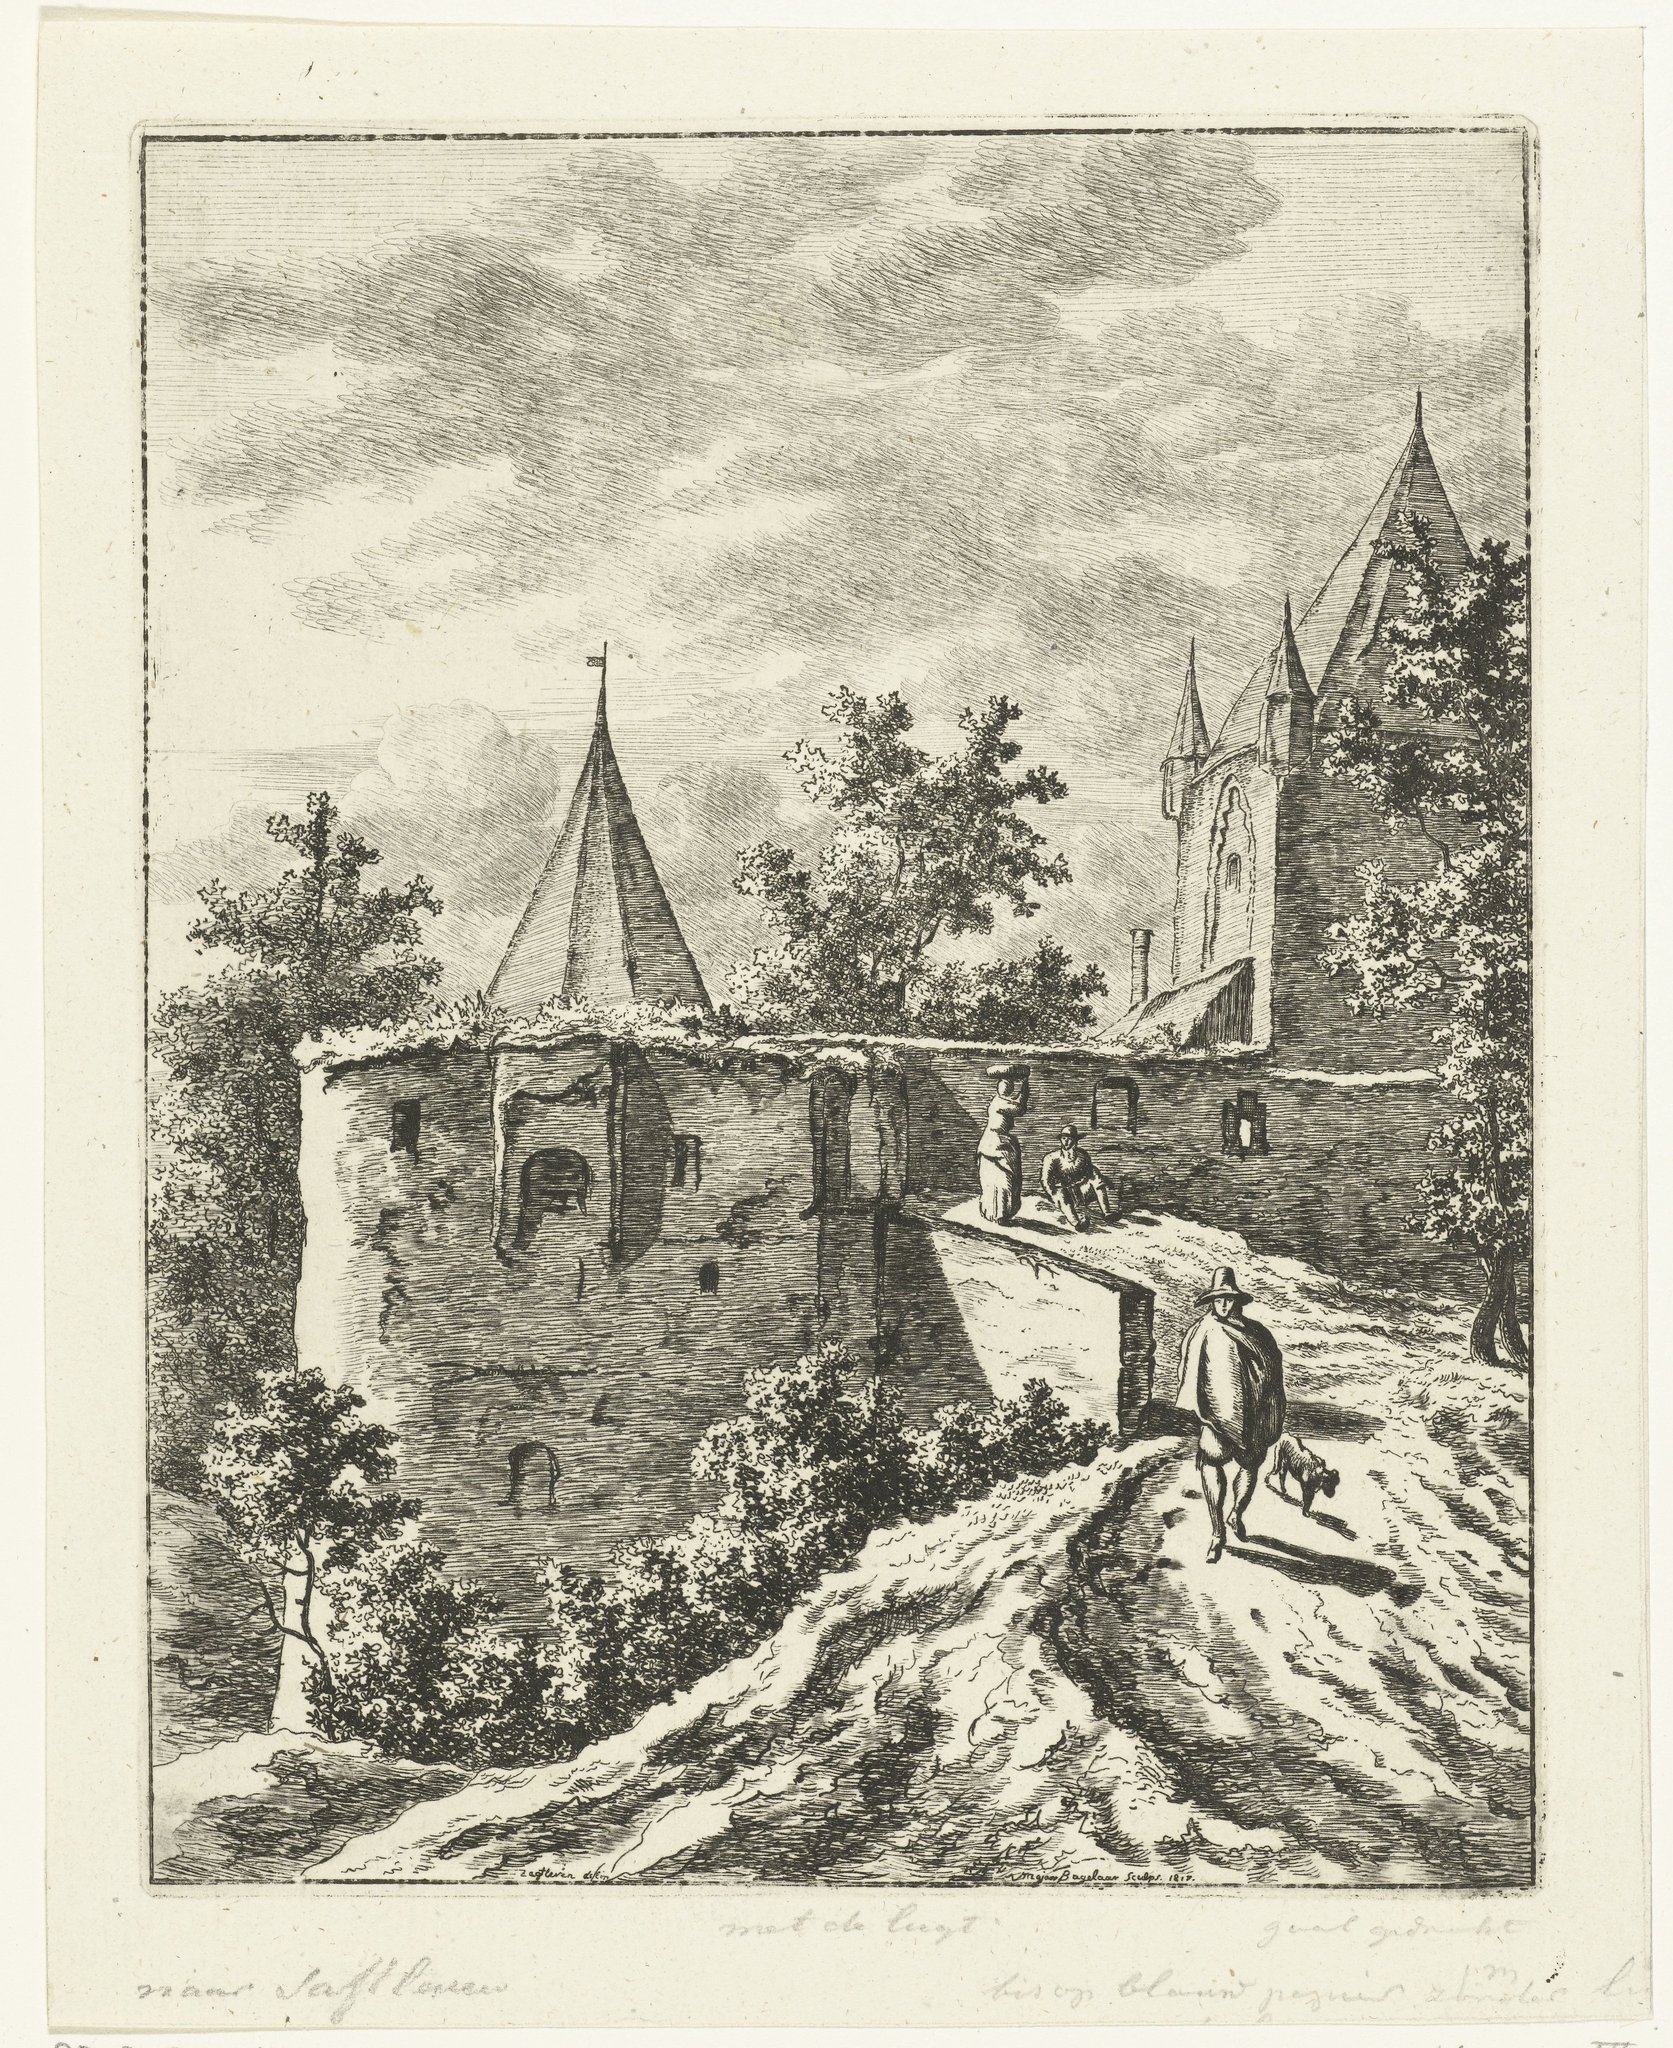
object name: print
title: De toegangsweg van het kasteel Saive bij Luik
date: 1818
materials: paper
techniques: drypoint, etching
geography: netherlands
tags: castle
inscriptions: collector's mark: Lugt 2228